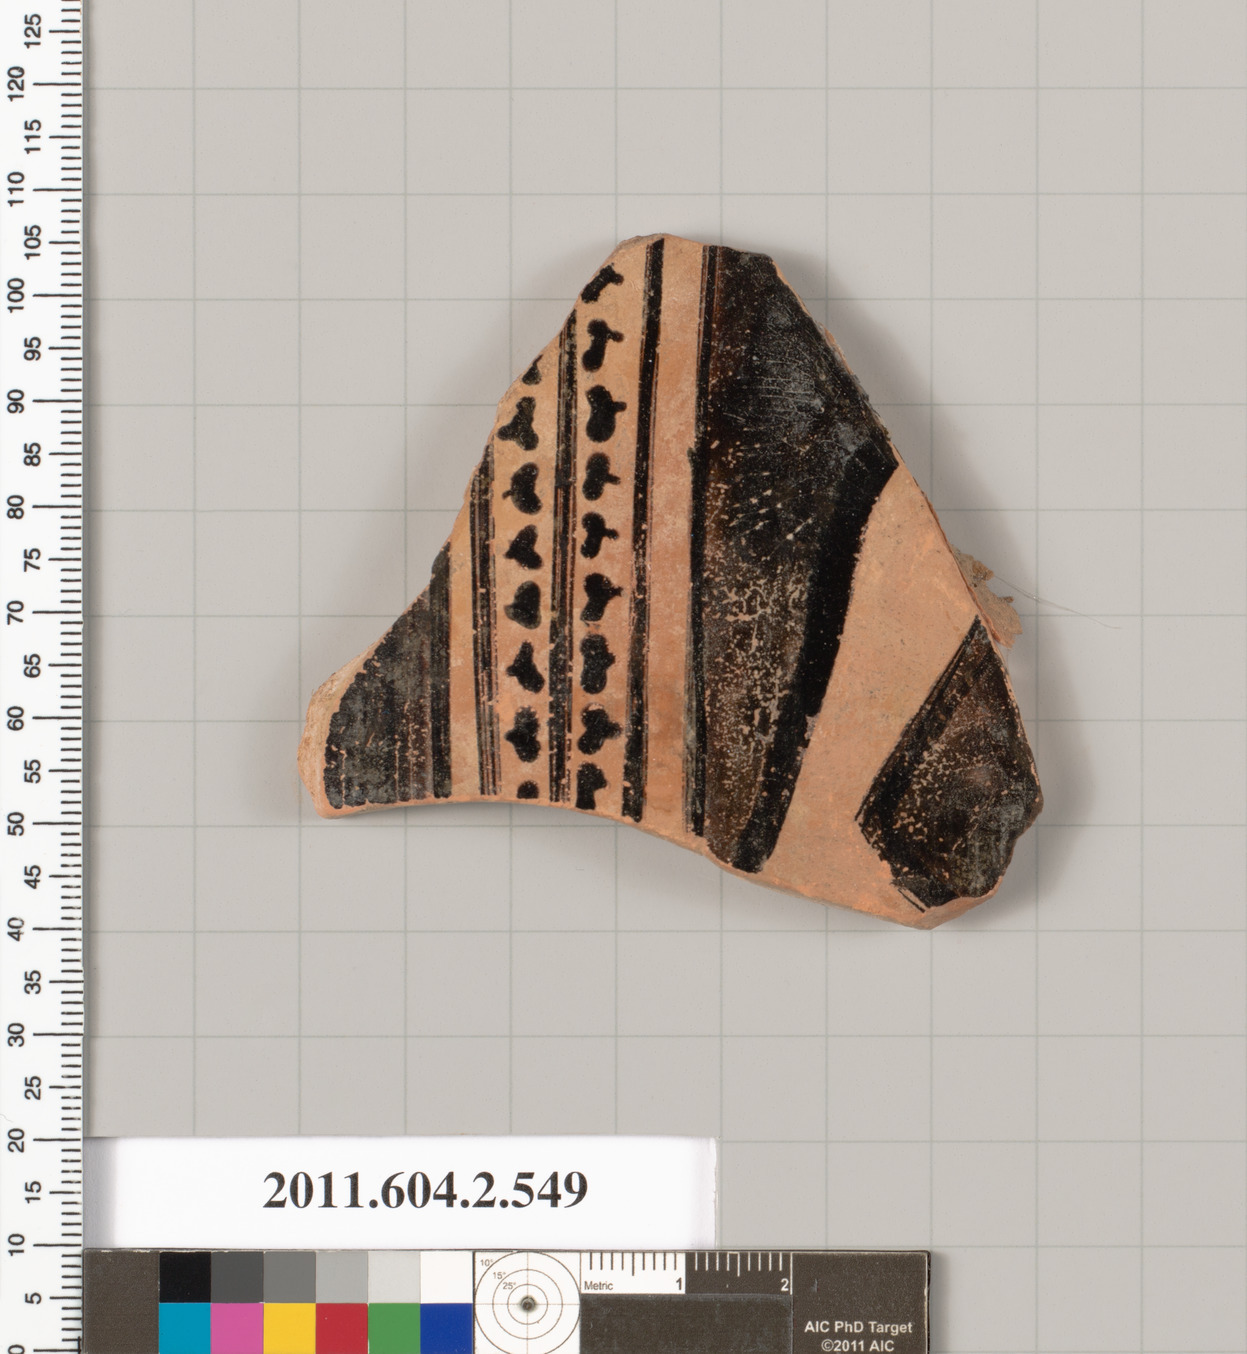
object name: column krater fragment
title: Terracotta fragment of a column-krater (bowl for mixing wine and water)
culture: greek, attic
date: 460-440 BCE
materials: terracotta